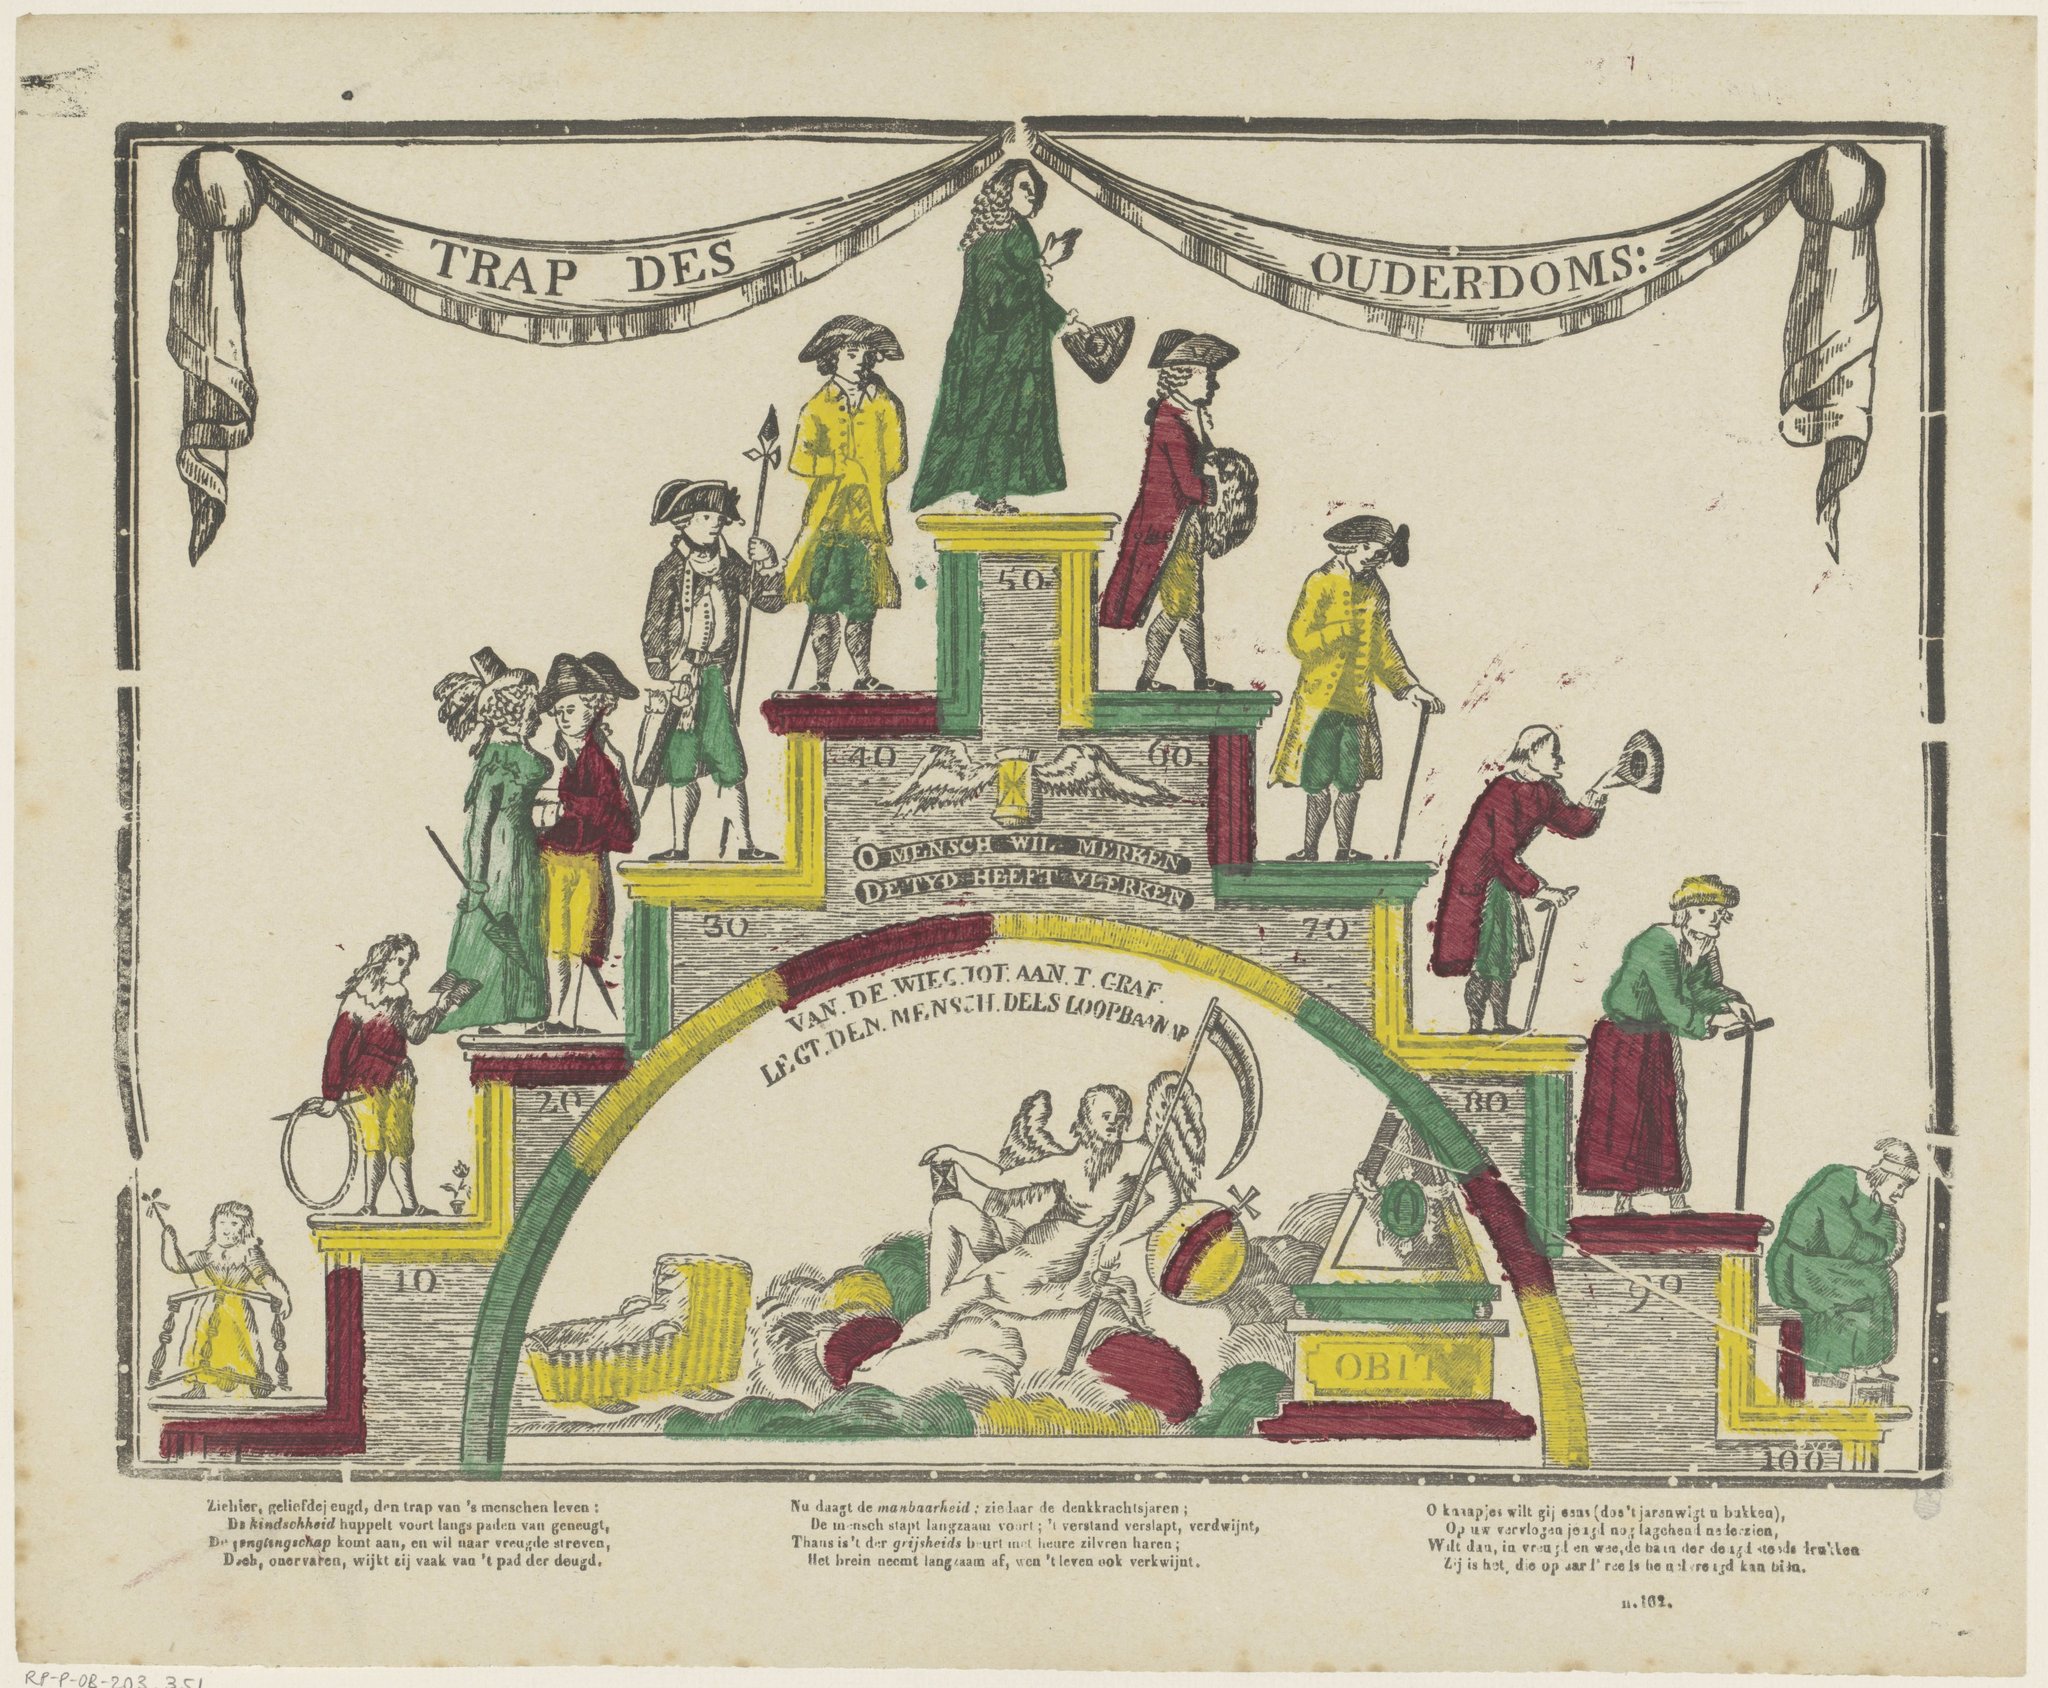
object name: popular print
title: Trap des ouderdoms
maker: dirk van lubeek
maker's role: print maker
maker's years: 1747-1811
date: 1856-1900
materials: paper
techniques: colour, letterpress printing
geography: turnhout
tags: the ages of man represented by a staircase, father time, man with wings and scythe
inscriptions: collector's mark: Lugt 2760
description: Een trap des ouderdoms: een mannentrap. Op de treden van de trap, in de vorm van een brug, staan mannen in de leeftijd van 0 tot 100 jaar. Onder de brug een voorstelling van een wieg, Vader Tijd en een grafmonument. Onder de voorstelling een twaalfregelig vers in drie kolommen. Genummerd rechtsonder: n. 162